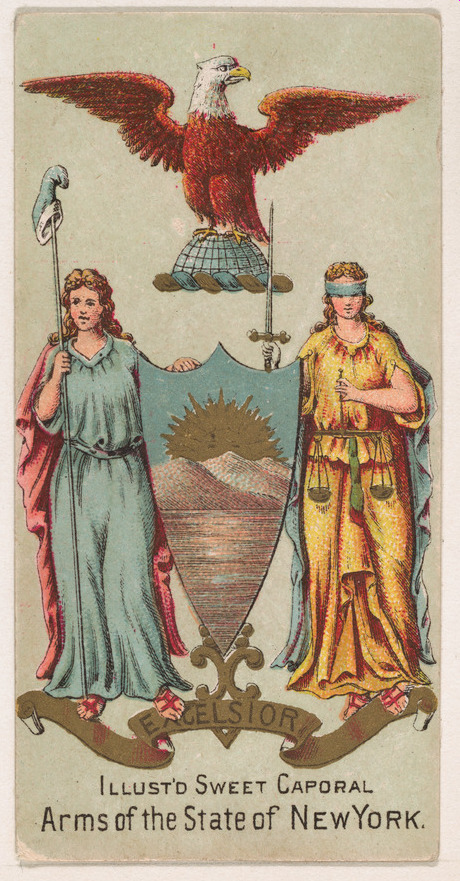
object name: print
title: Arms of the State of New York, from the Military Series (N224) issued by Kinney Tobacco Company to promote Sweet Caporal Cigarettes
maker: kinney brothers tobacco company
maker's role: publisher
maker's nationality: american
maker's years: 1869-2011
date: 1888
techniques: color lithograph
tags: eagles,swords,women,coat of arms,scales